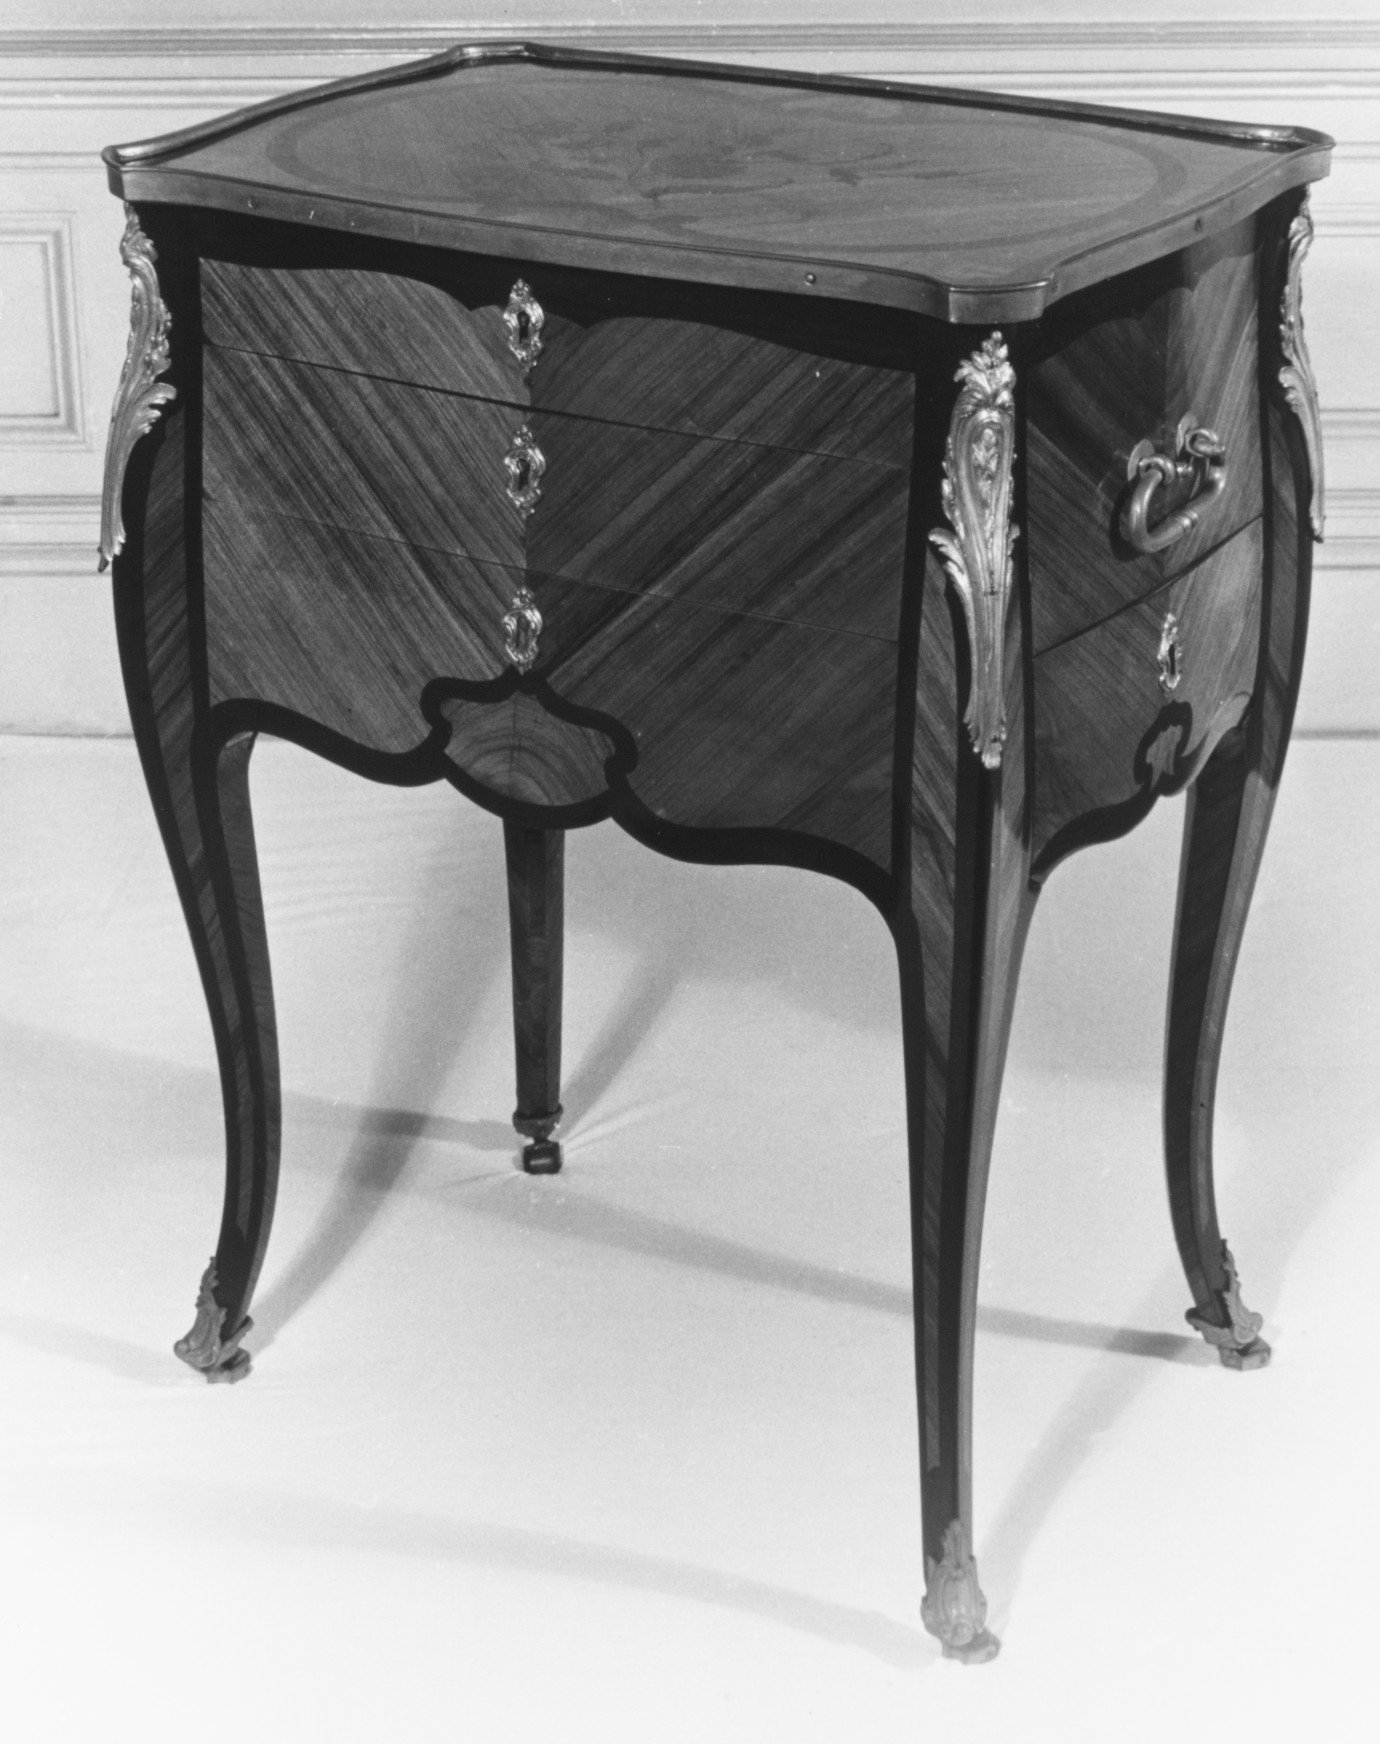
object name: table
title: Rectangular table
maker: bernard ii van risenburgh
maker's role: maker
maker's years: 1696-1767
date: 1765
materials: brass, gilt bronze, leather, wood